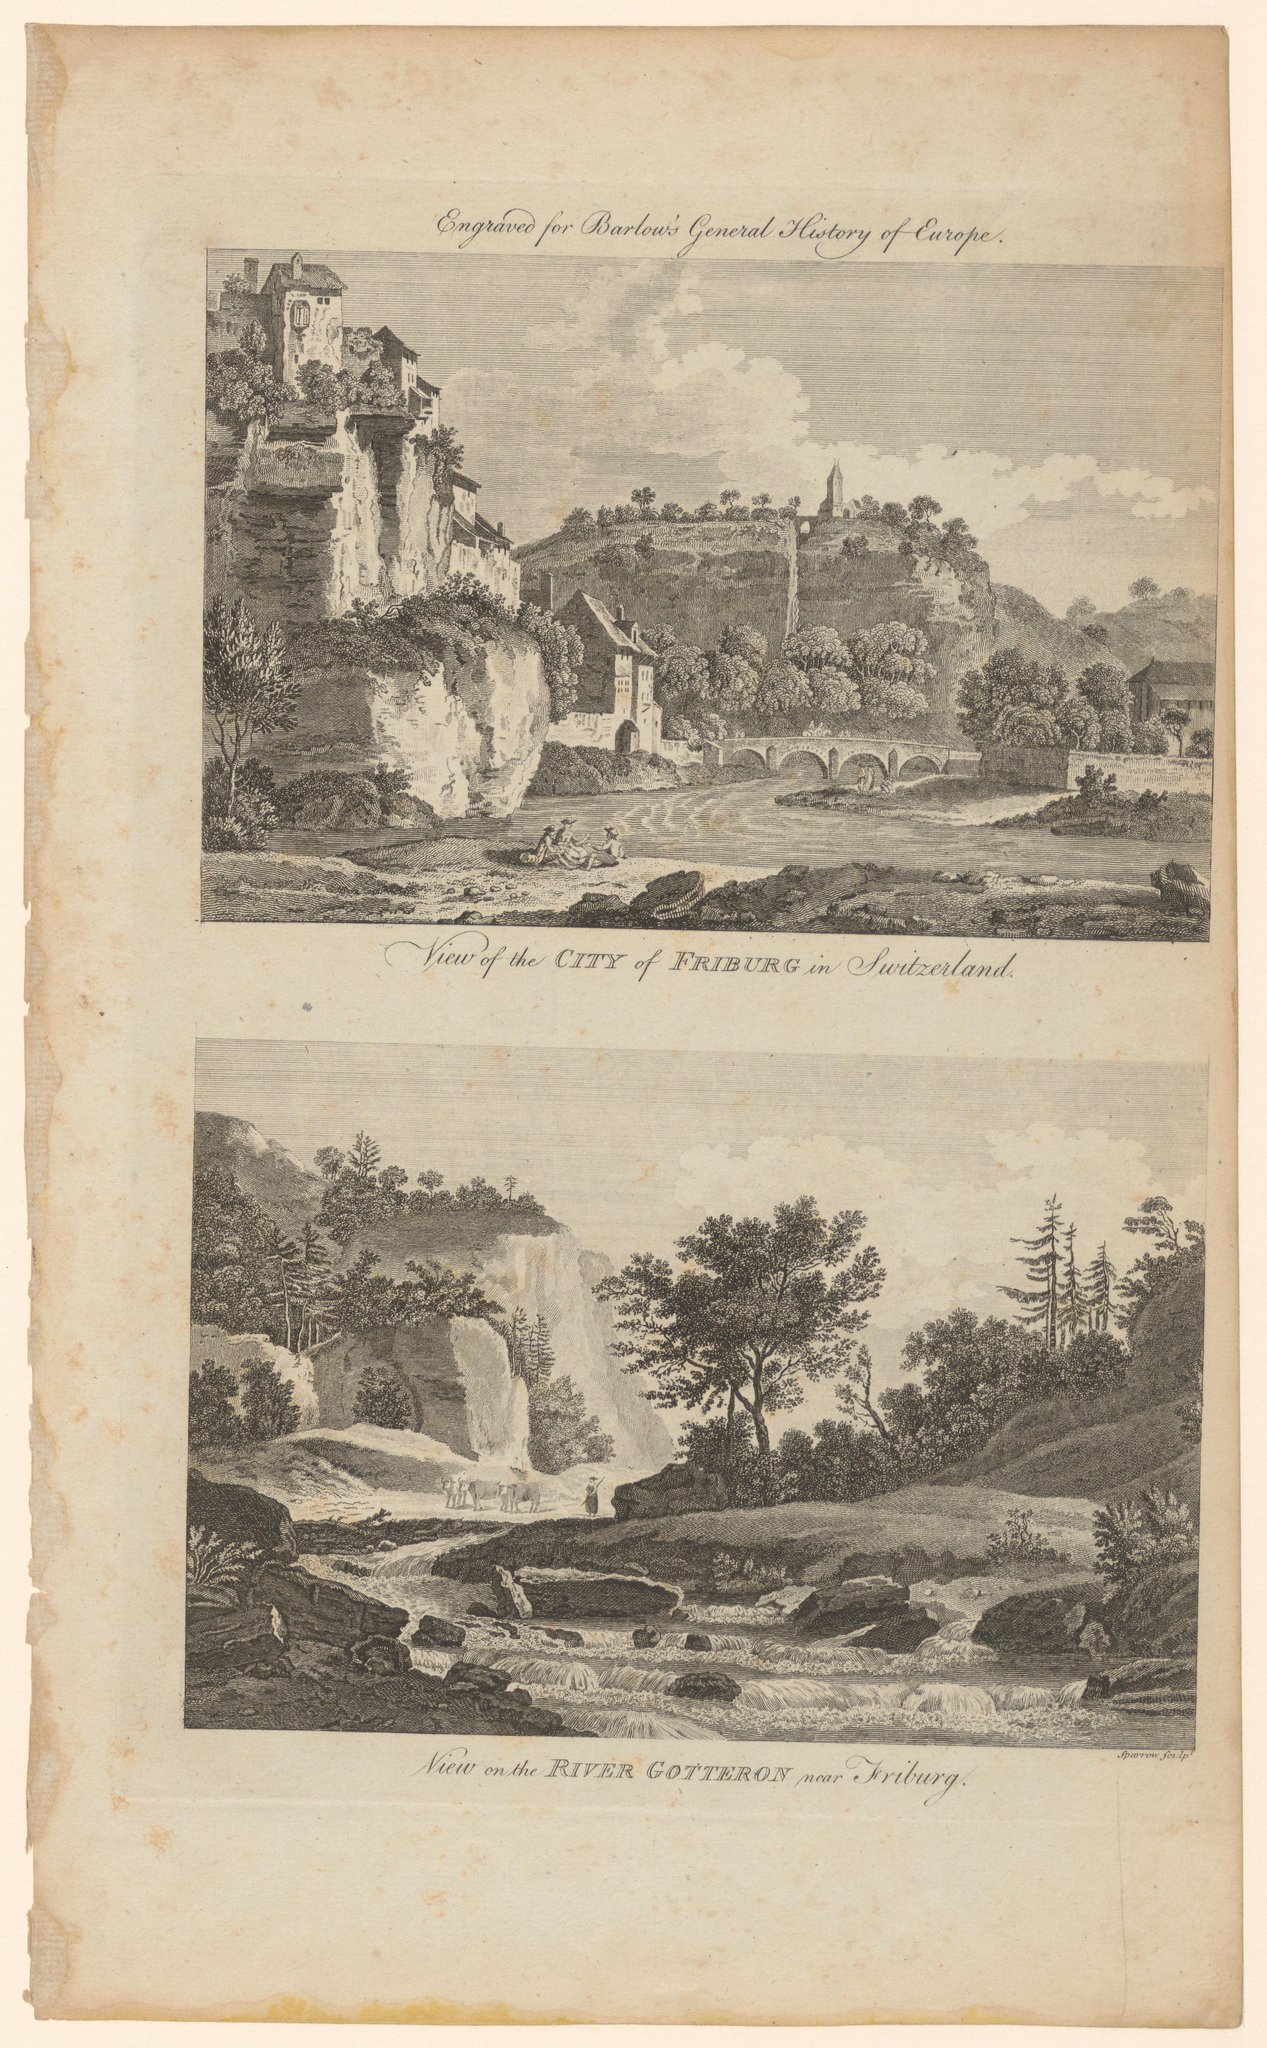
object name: book illustration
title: View of the City of Friburg in Switzerland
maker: sparrow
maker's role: print maker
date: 1790-1791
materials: paper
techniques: etching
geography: london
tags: city-view in general; 'veduta', river, bridge in city across river, canal, etc.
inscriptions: collector's mark: Lugt 2228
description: Prent uit: Barlow, Percival. The General History of Europe (...). Londen: William & James Stratford, [1790-1791].